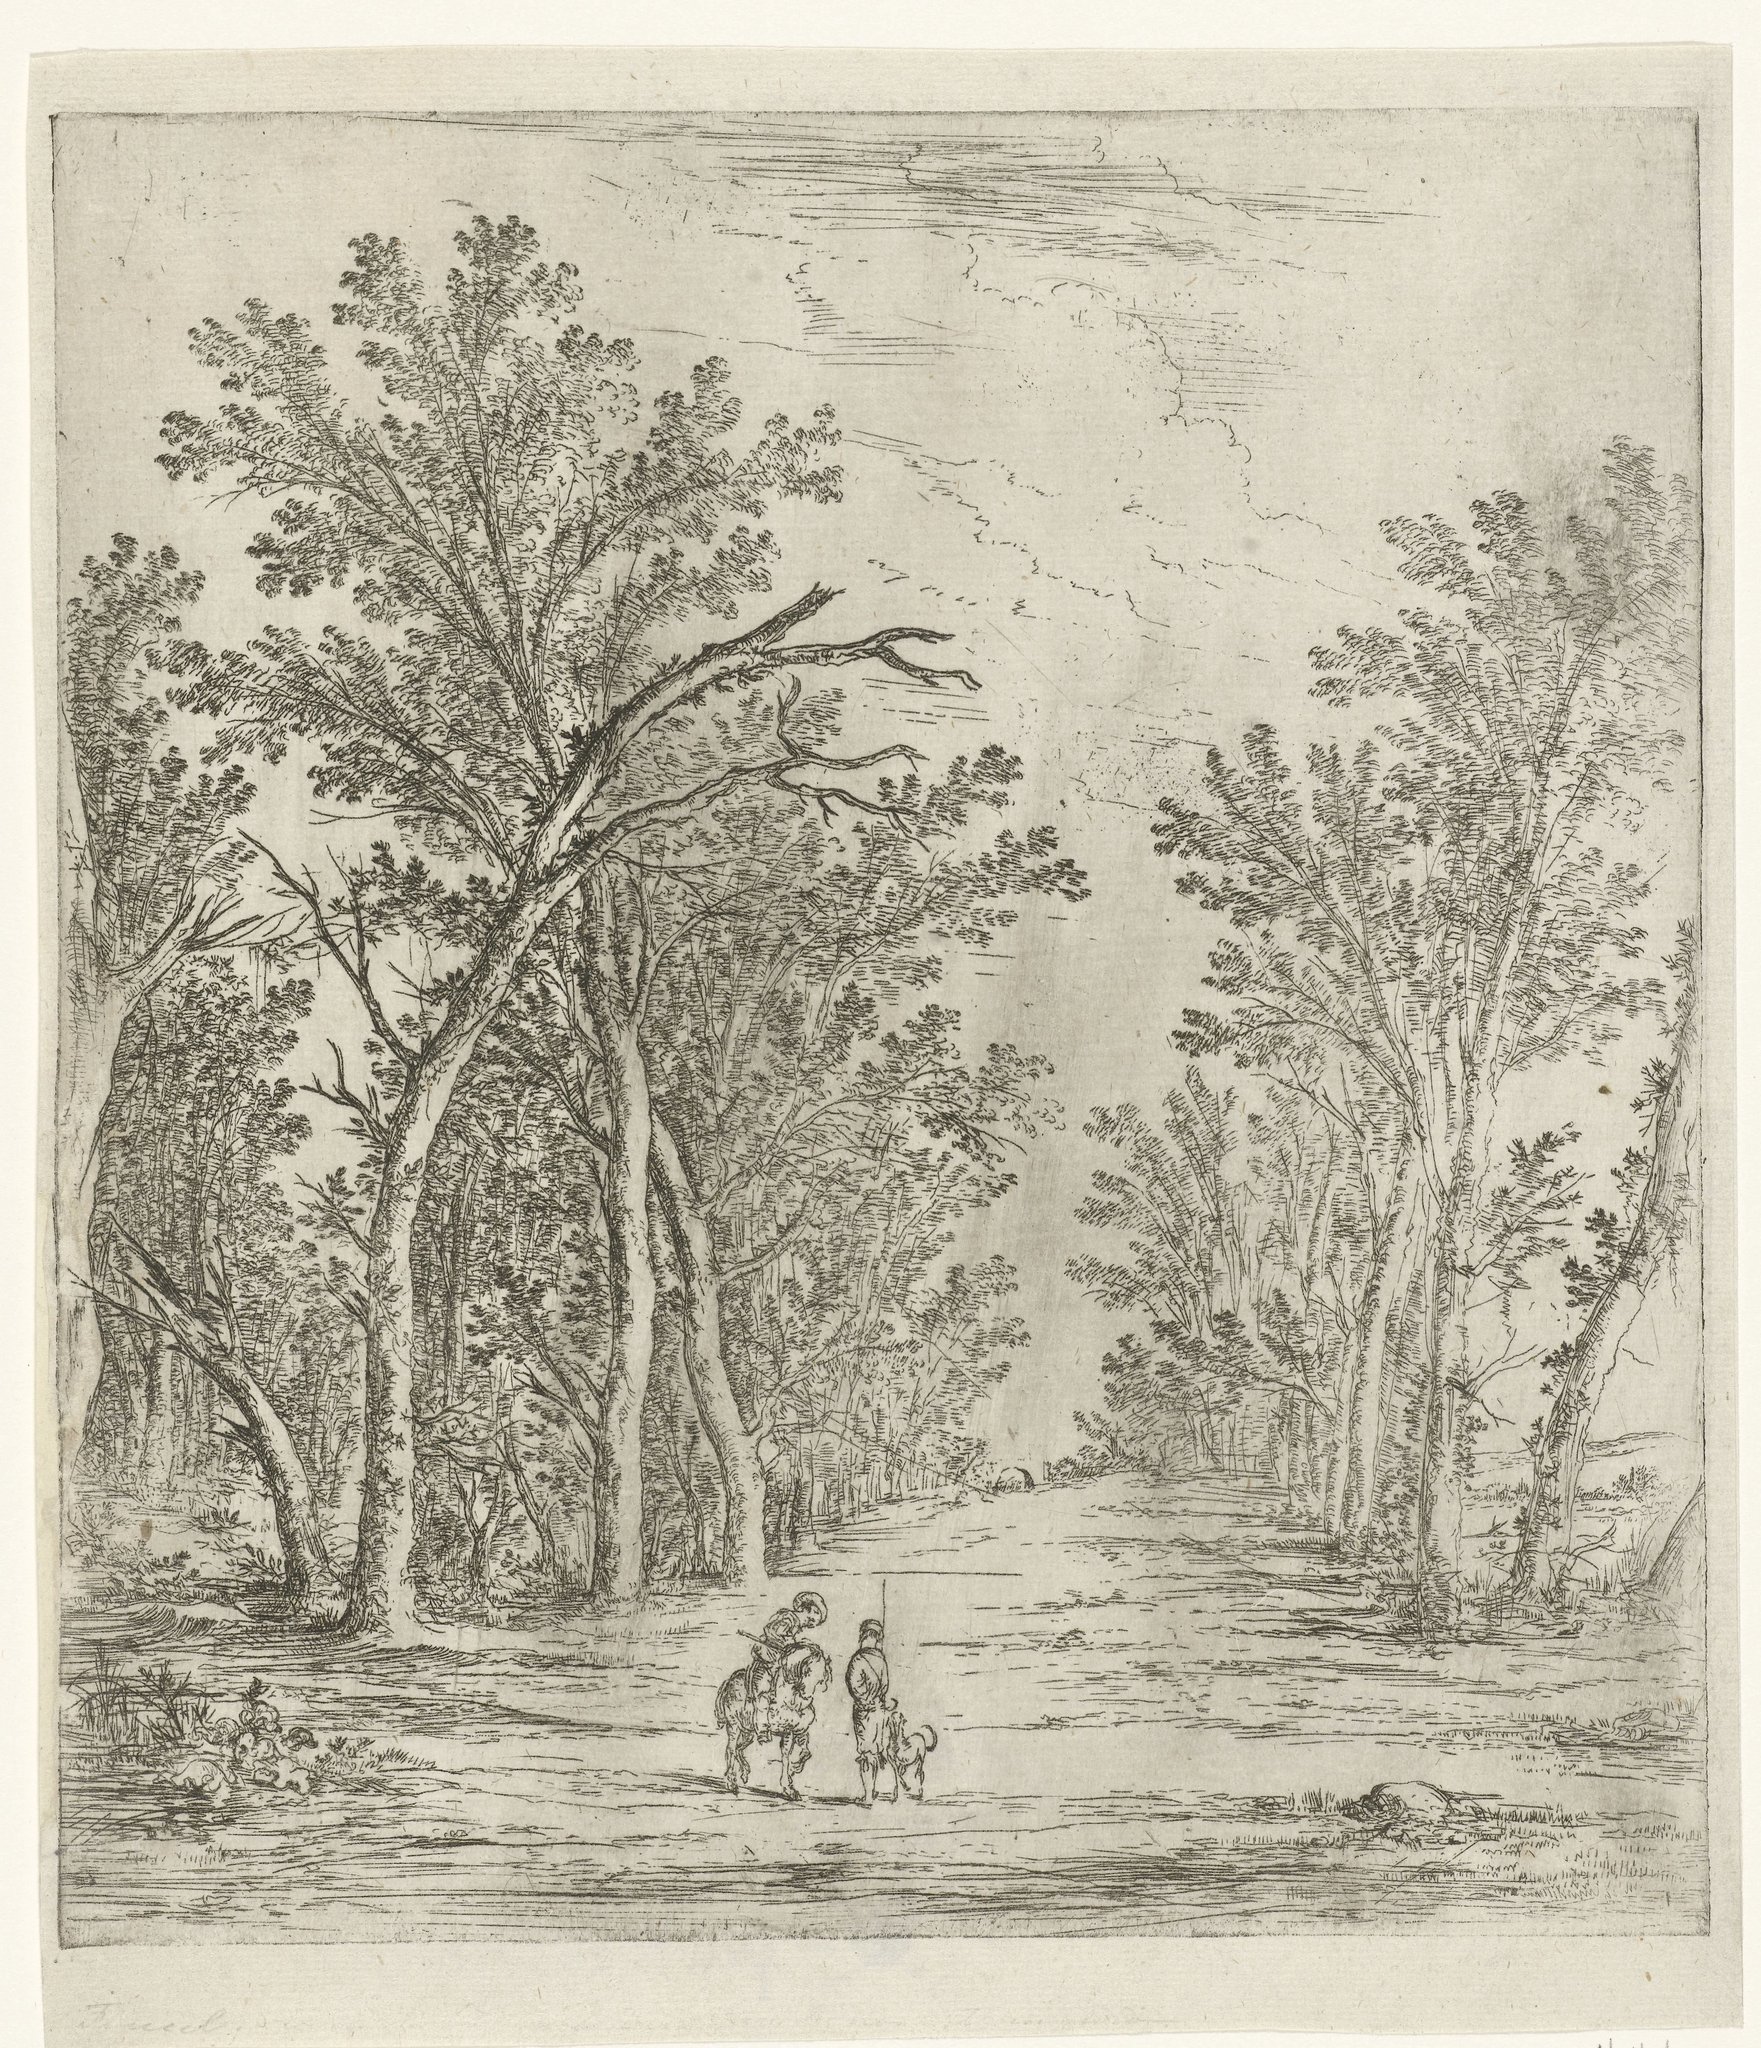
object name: print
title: Bospad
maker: jan fouceel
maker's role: print maker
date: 1665-1675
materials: paper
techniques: etching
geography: antwerp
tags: riding a horse, ass, or mule; rider, horseman, forest path or lane, dog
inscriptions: collector's mark: Lugt 2228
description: Bospad met een ruiter, een wandelaar en een hond.